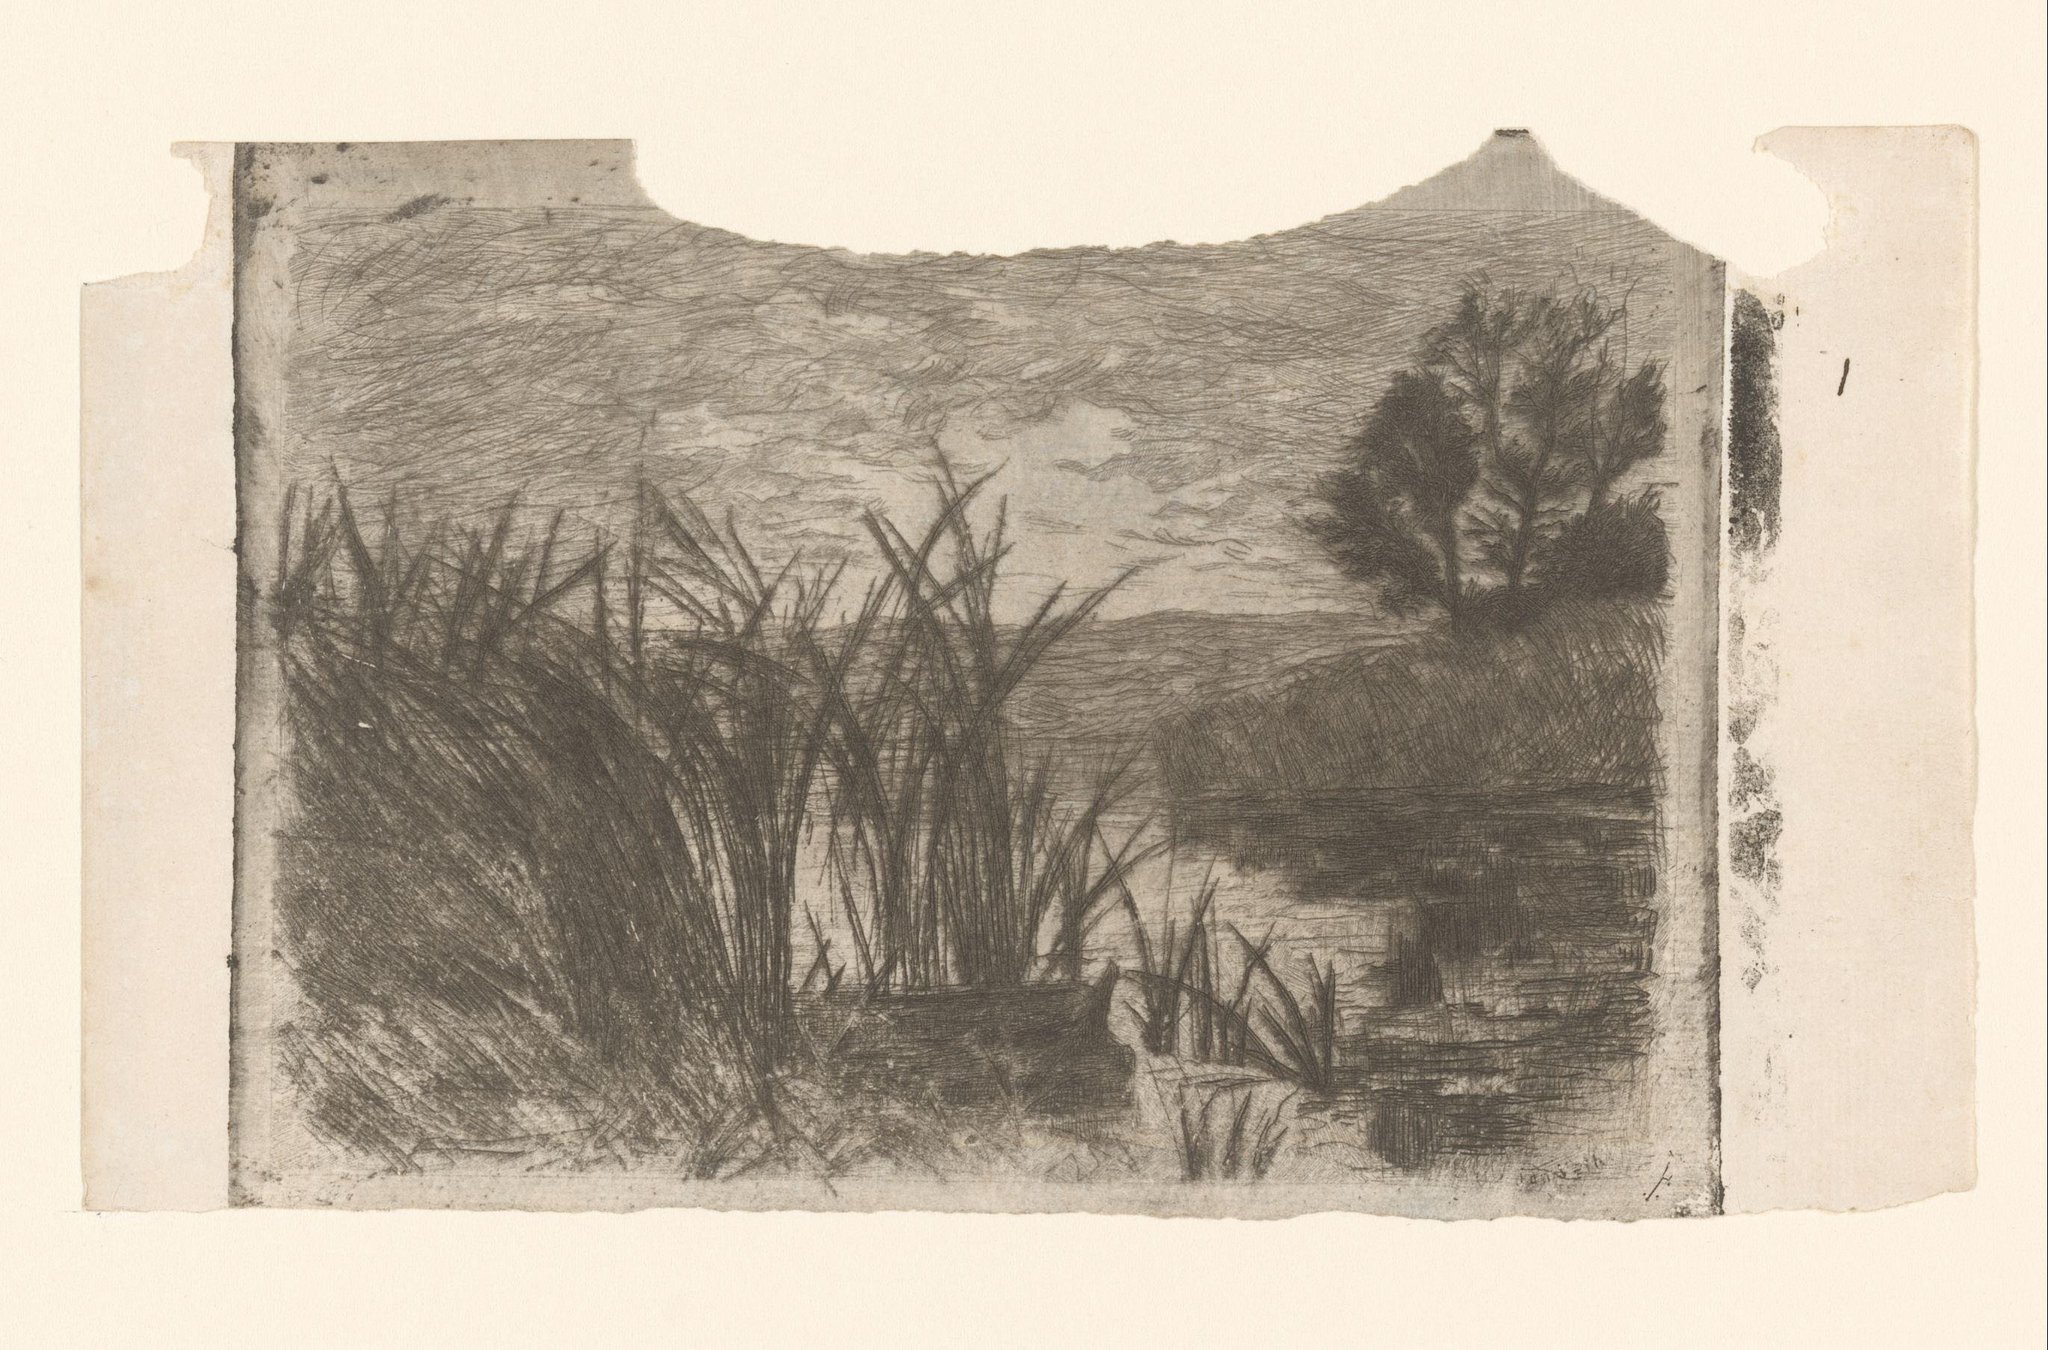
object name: print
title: Landschap met water, riet en roeiboot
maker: jan veth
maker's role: designer, draughtsman, painter, print maker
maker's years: 1864-1925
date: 1887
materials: paper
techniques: etching, intaglio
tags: landscapes with waters, waterscapes, seascapes (in the temperate zone), rowing-boat, canoe, etc., plants and herbs: reed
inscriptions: collector's mark: Lugt 2228